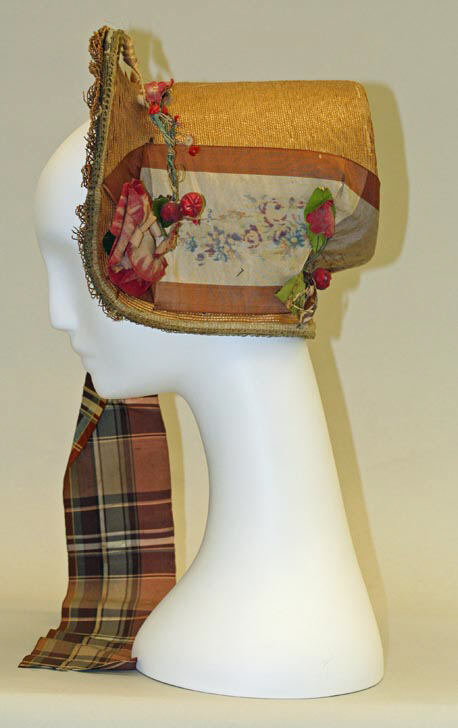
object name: bonnet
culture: american or european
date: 1801-1900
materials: fiber